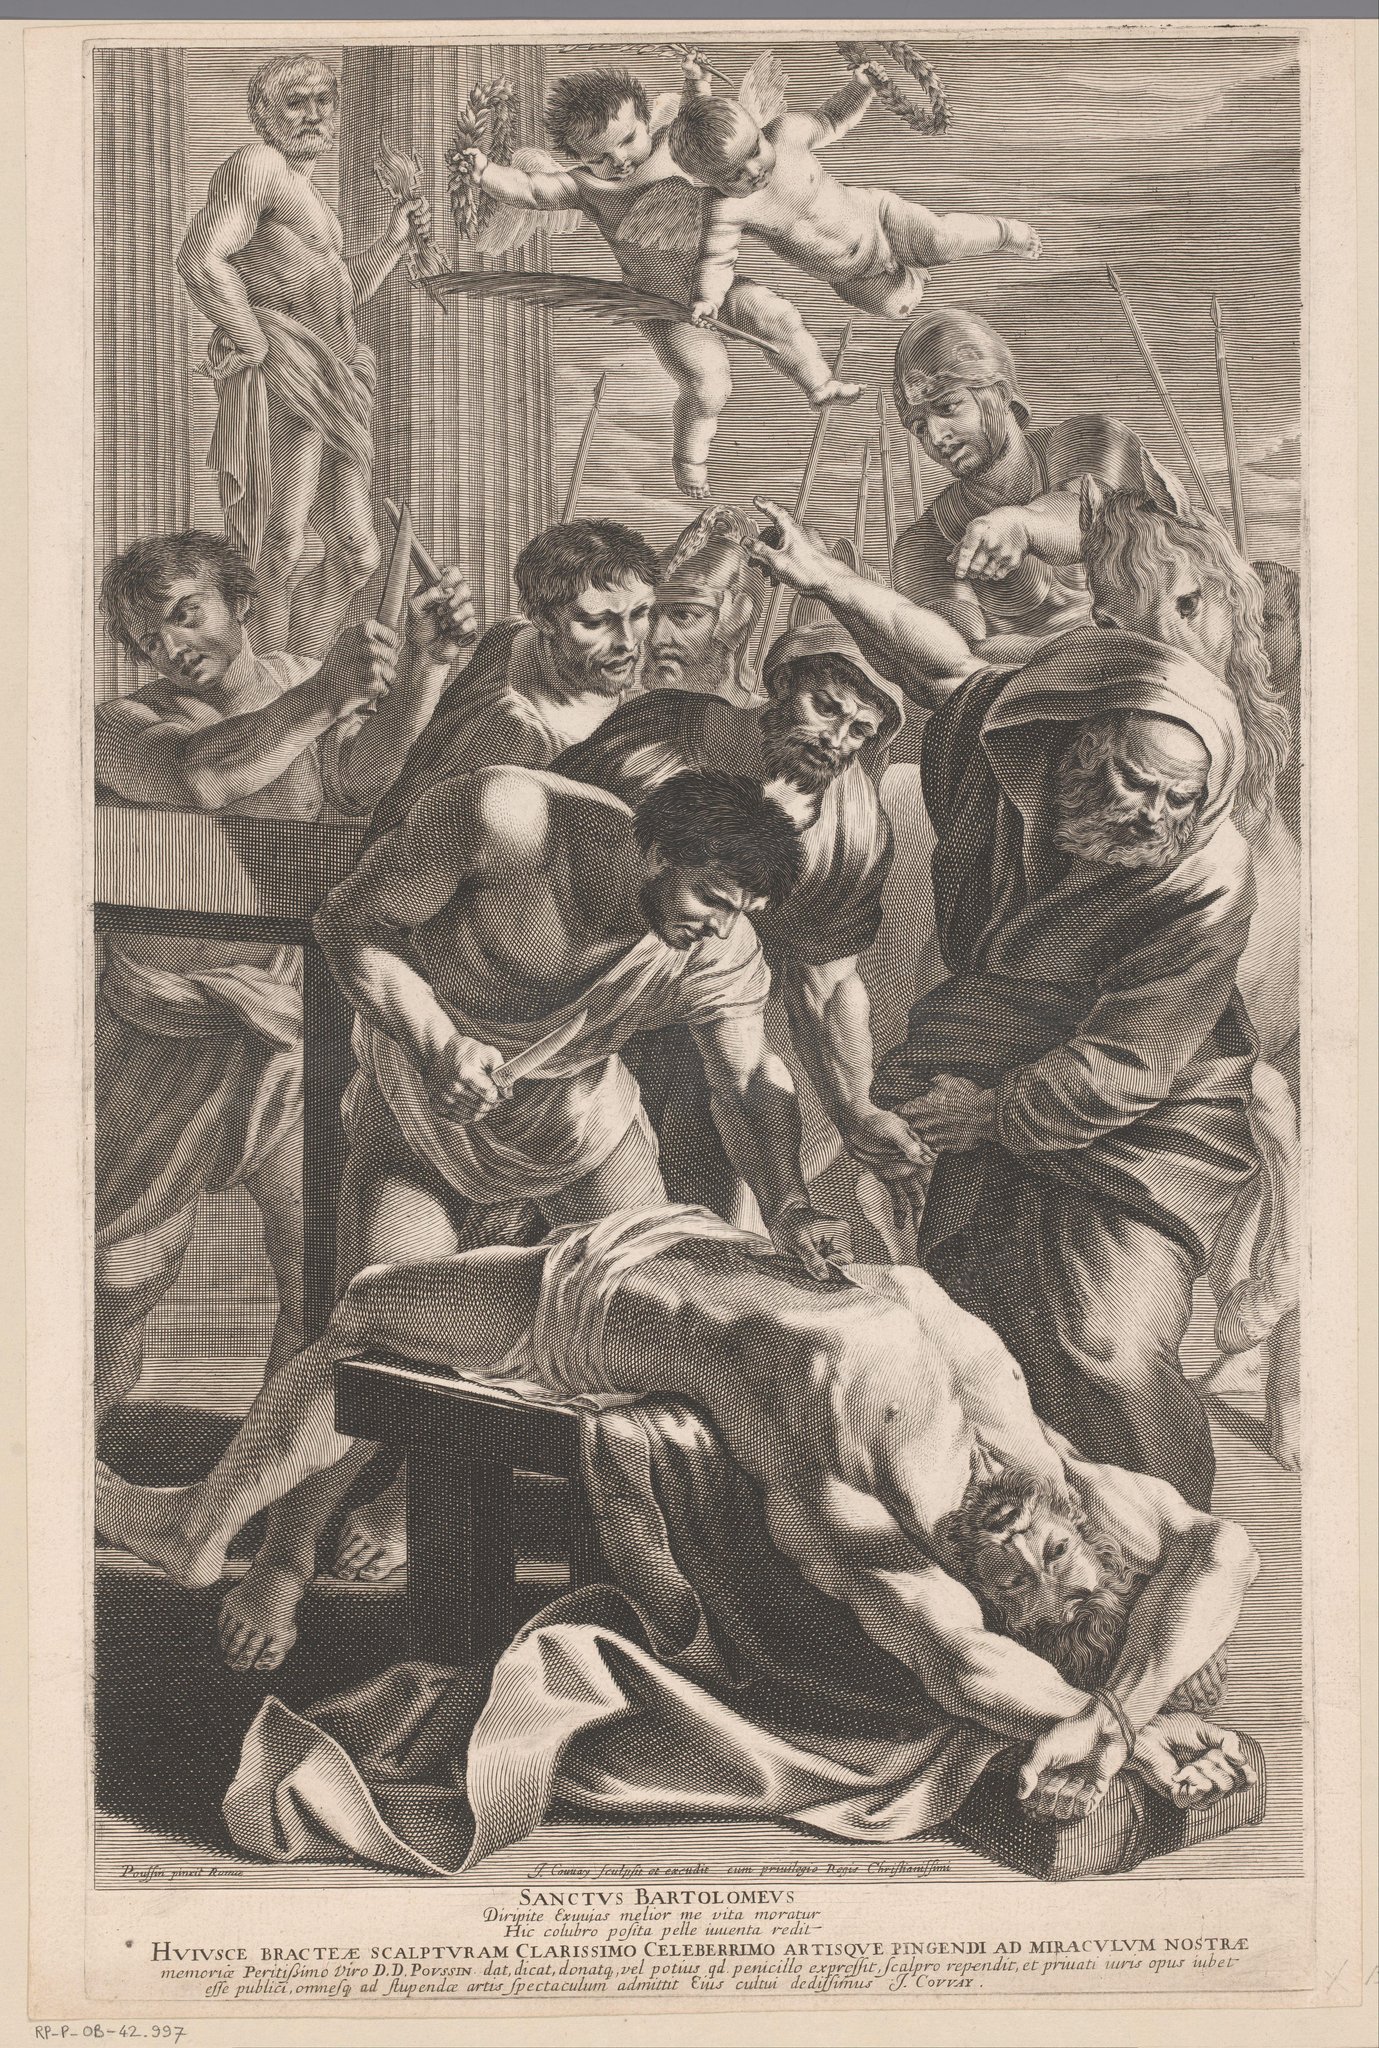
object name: print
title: Martelaarschap van de Heilige Bartholomeus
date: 1632-1675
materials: paper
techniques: engraving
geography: rome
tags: bartholomew flayed alive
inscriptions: collector's mark: Lugt 240, inscription: ‘2 1/2 gul[den].’